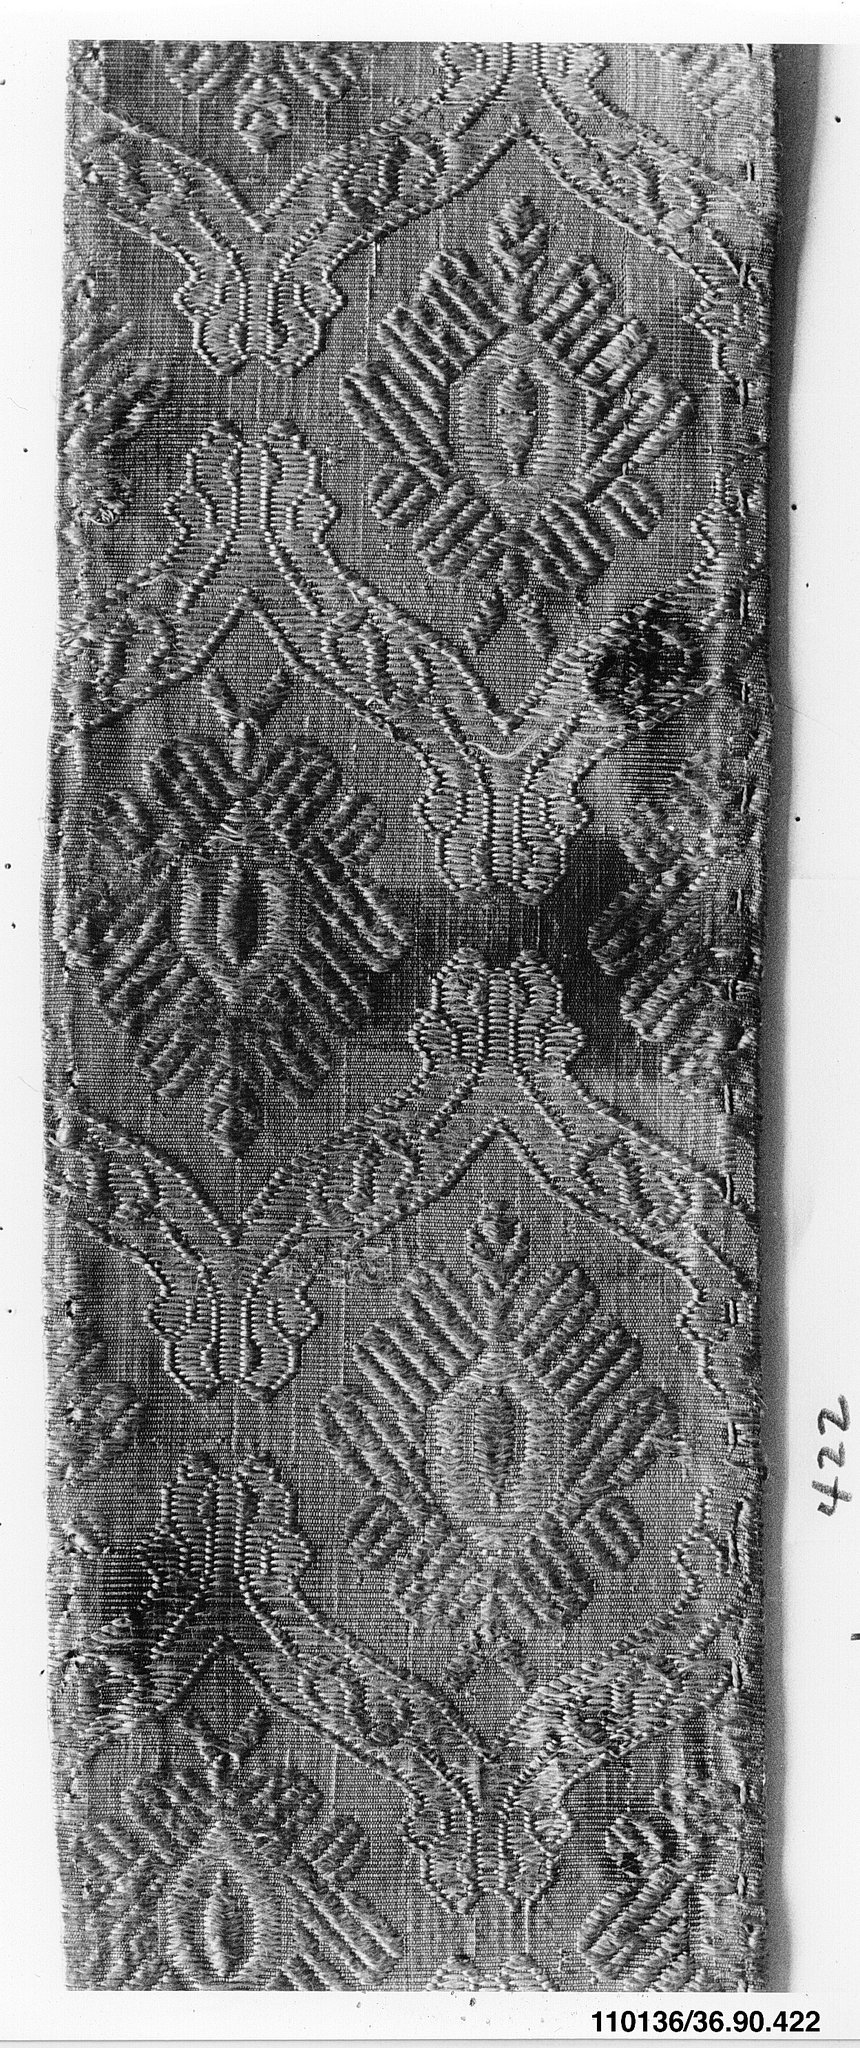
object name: piece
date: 1501-1700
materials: silk